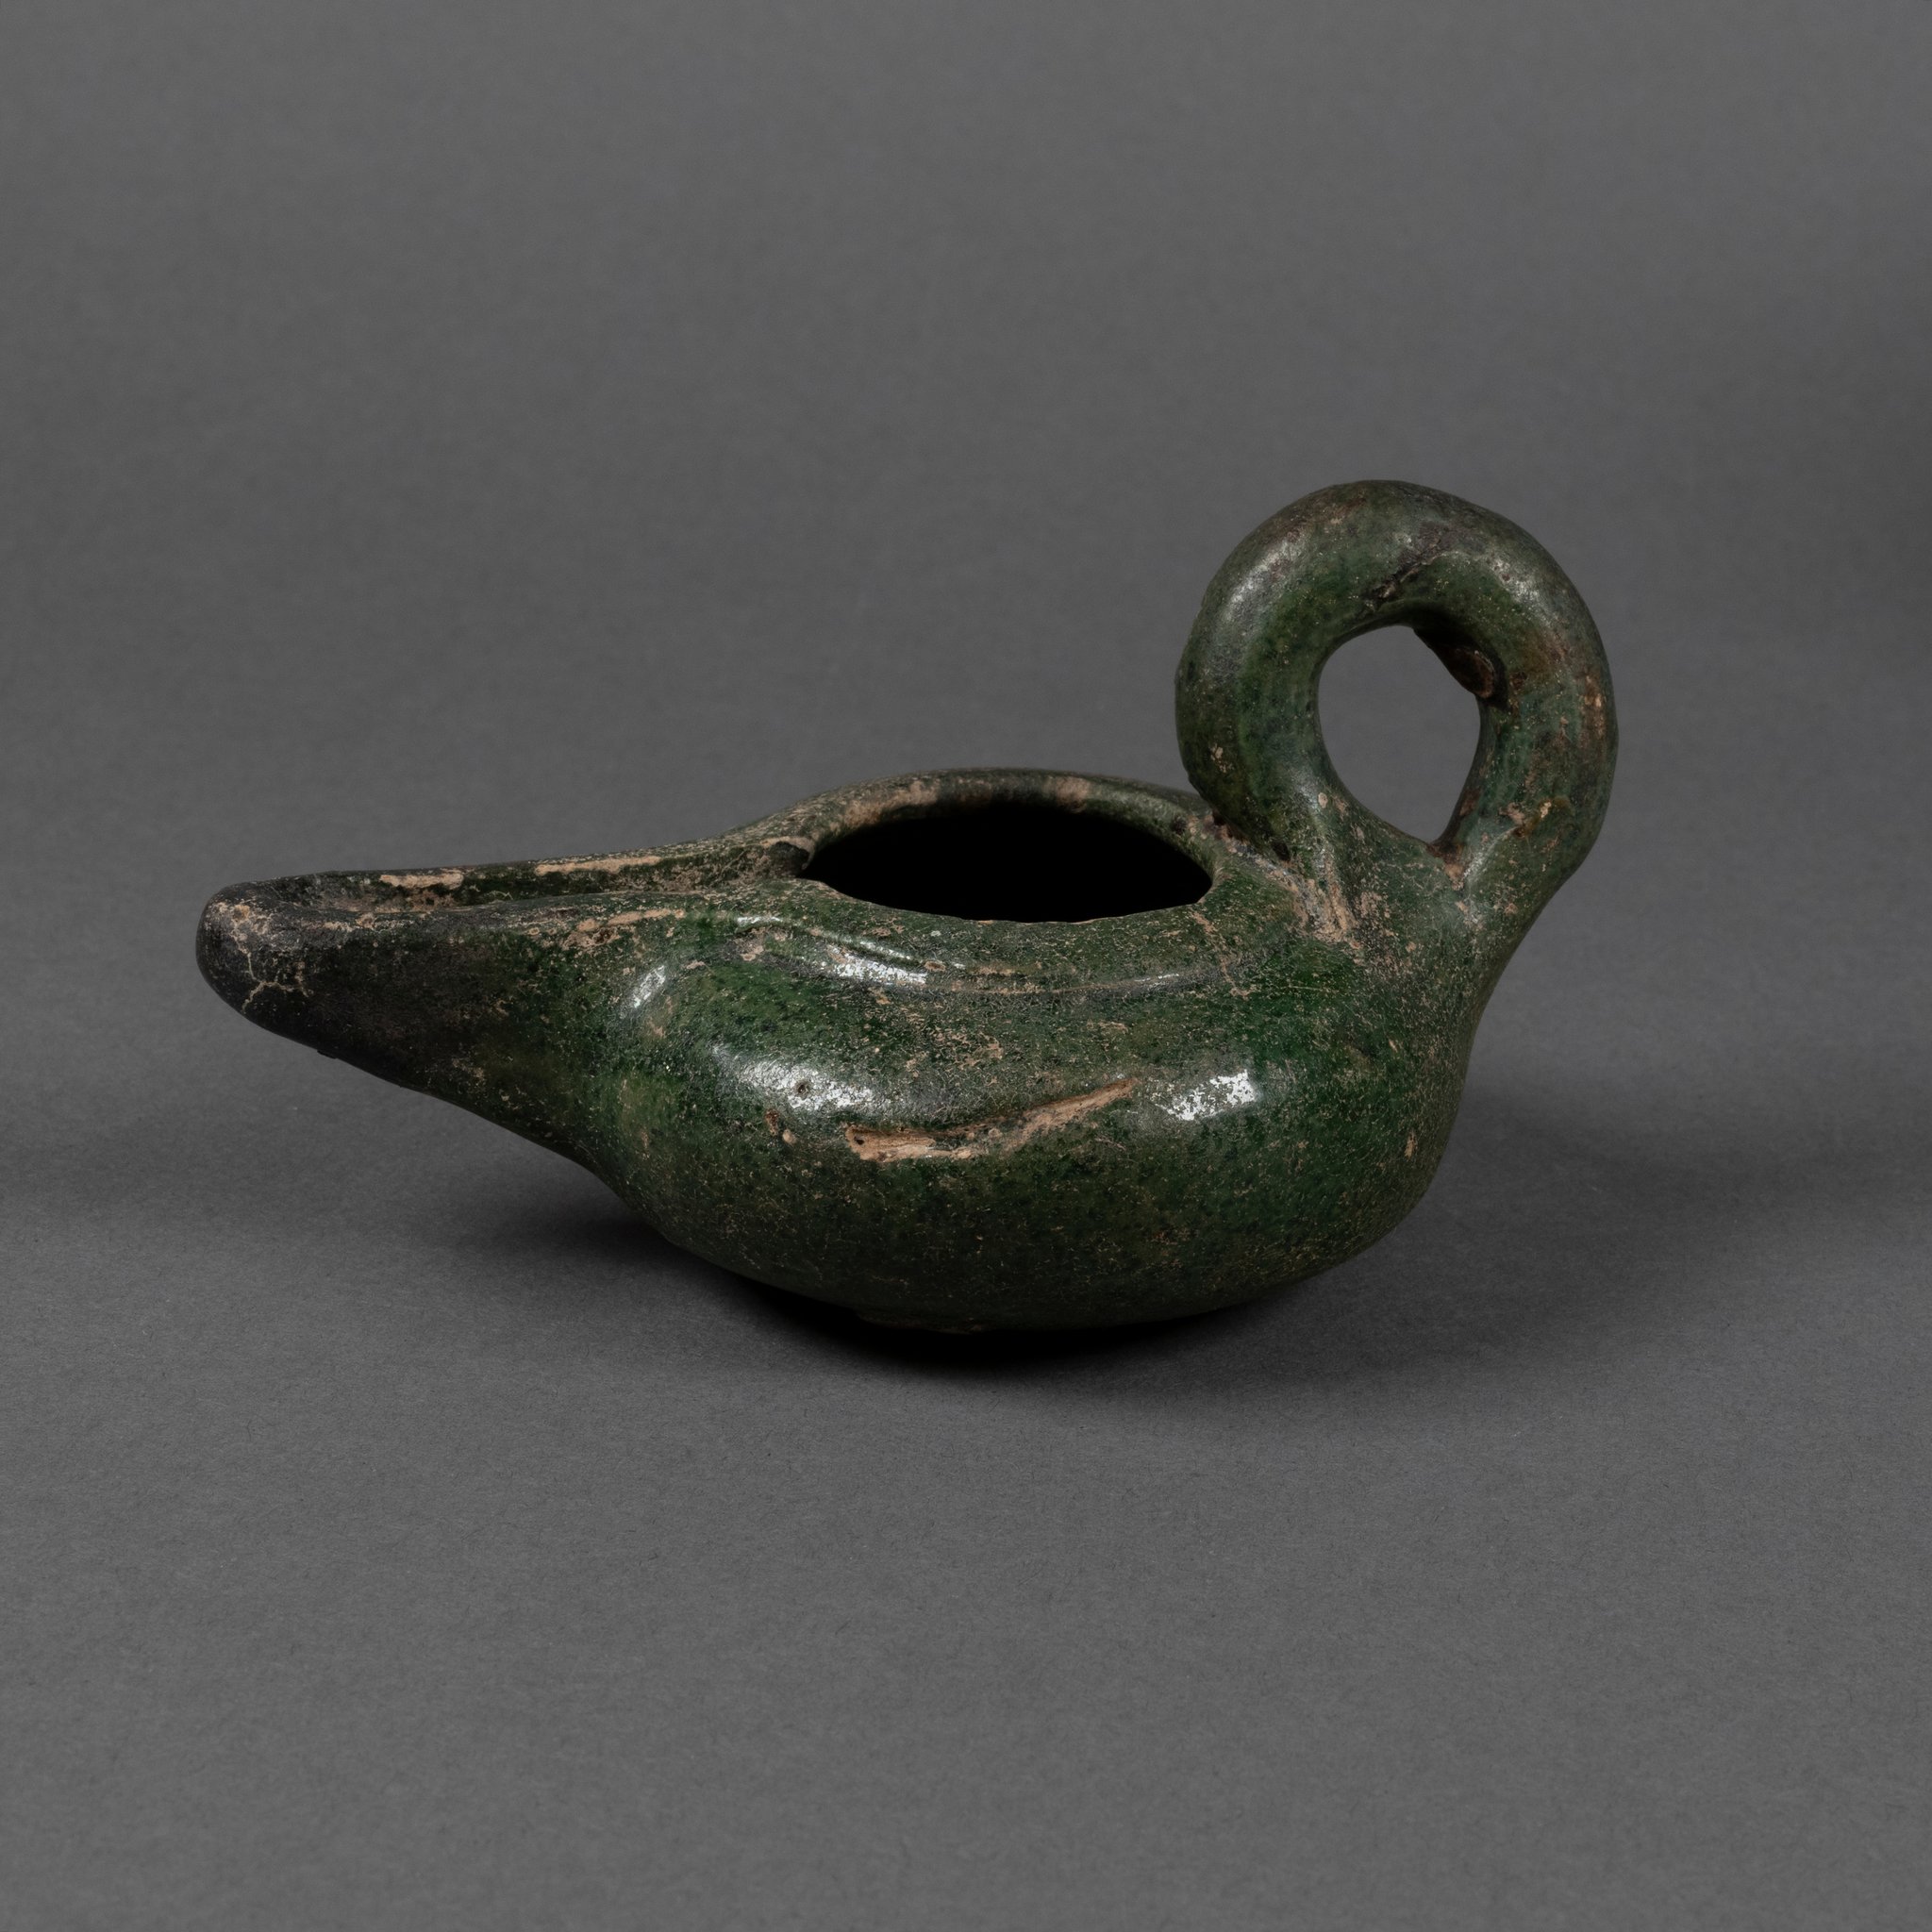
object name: lamp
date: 1501-1700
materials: earthenware, glaze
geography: iran